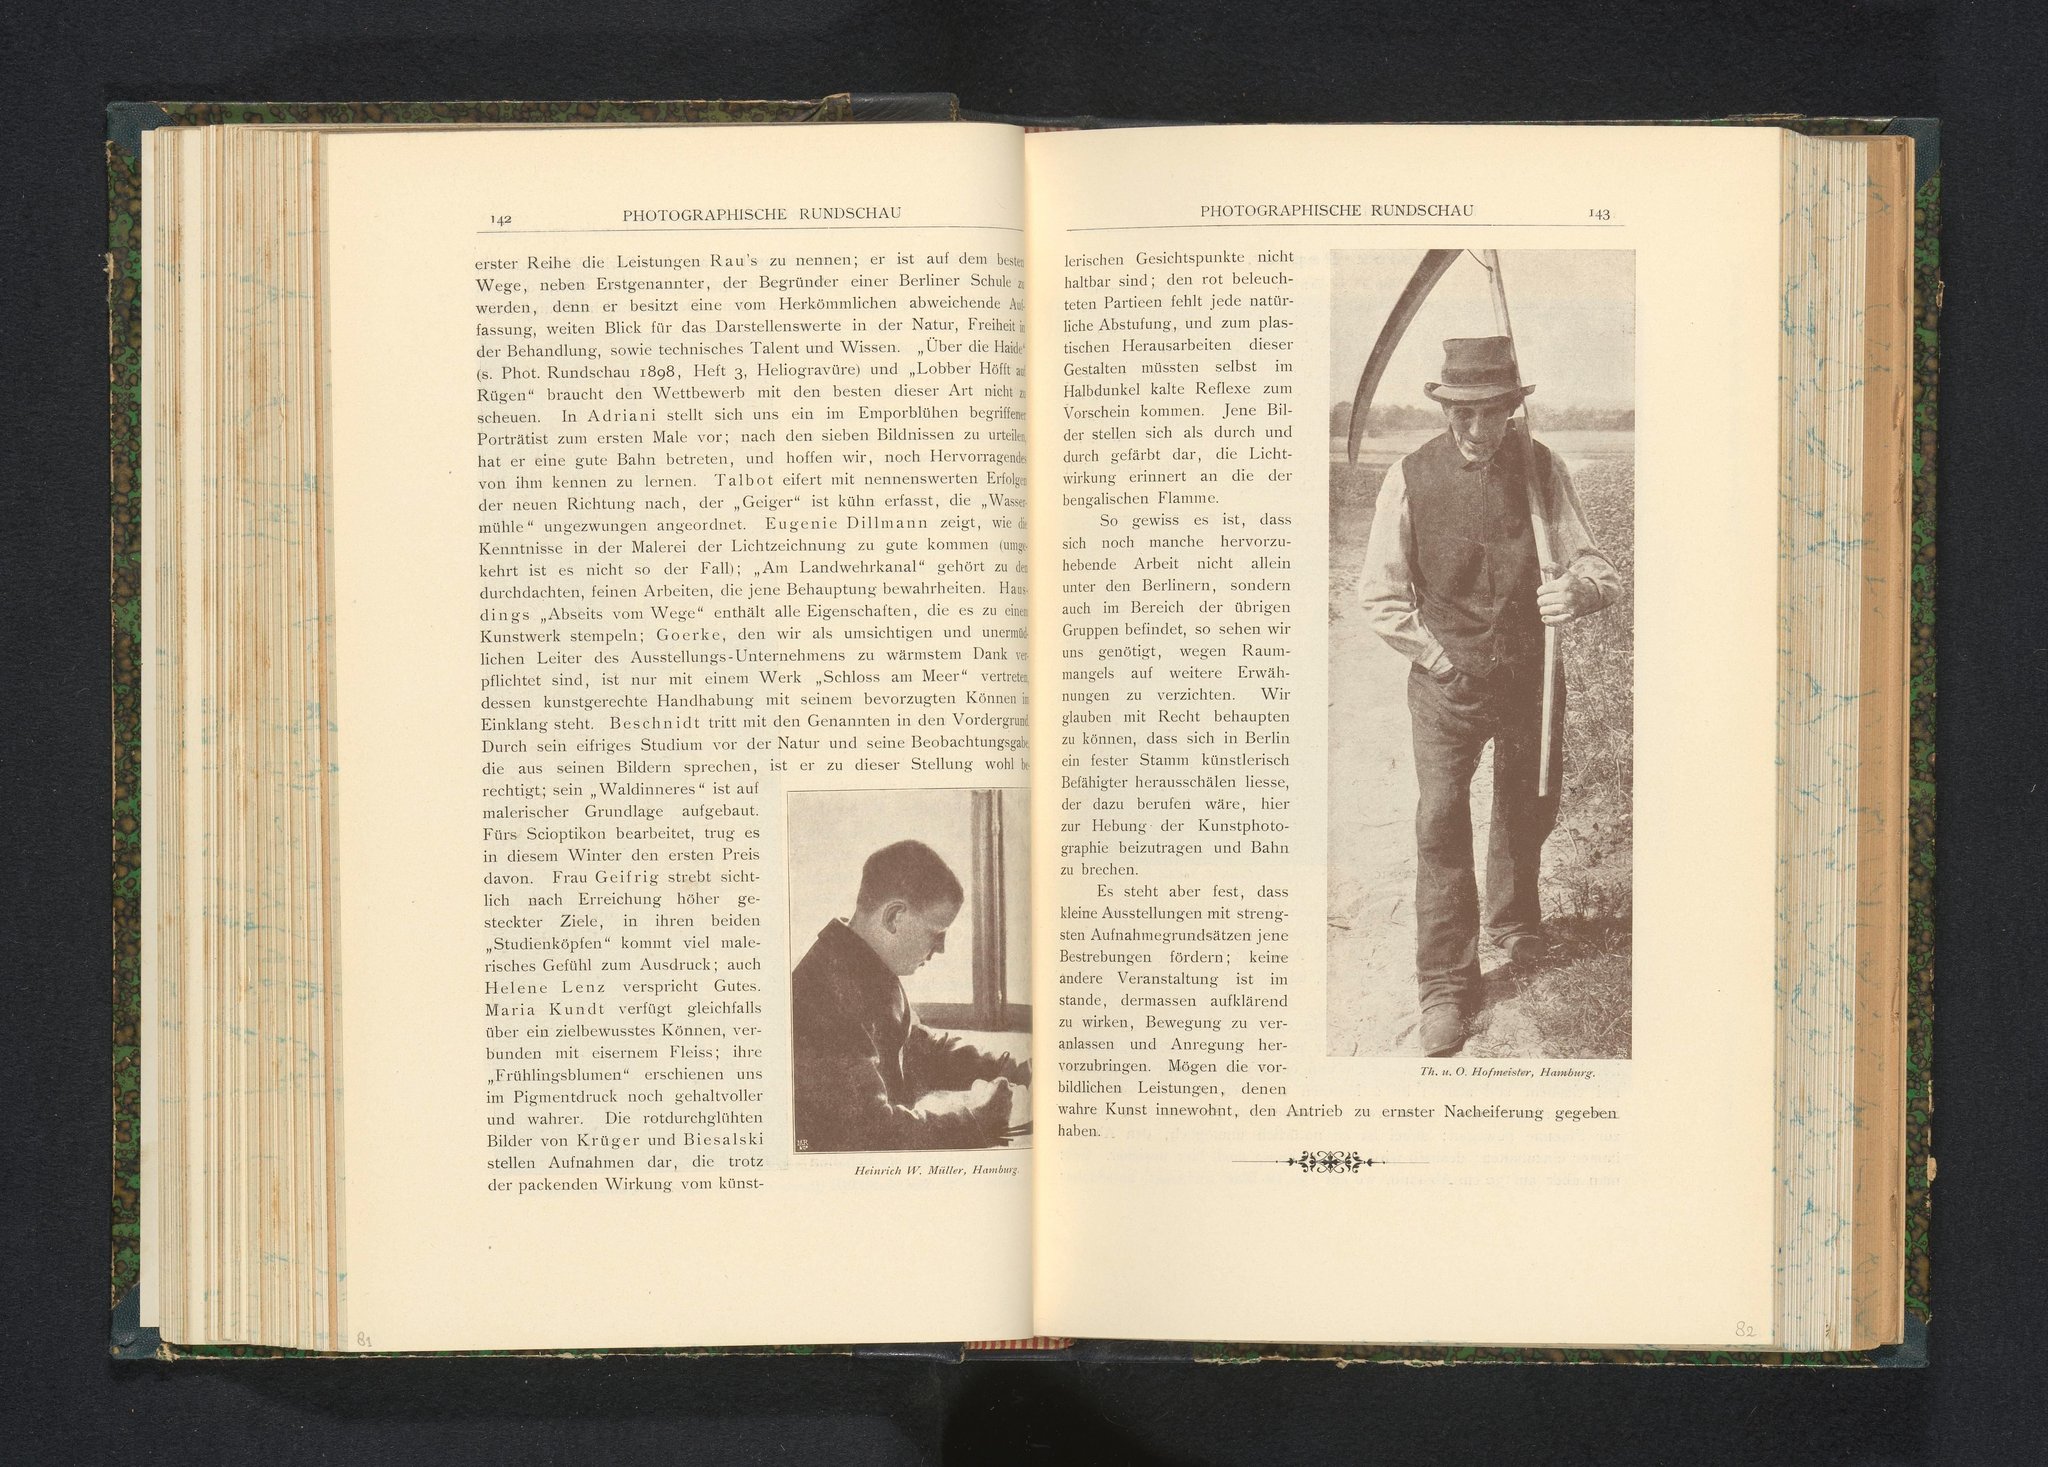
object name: photomechanical print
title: Boer op het land met een zeis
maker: th. u. o. hofmeister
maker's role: fotograaf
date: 1894-1899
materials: paper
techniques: autotype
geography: berlin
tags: agricultural implements: scythe, farmers